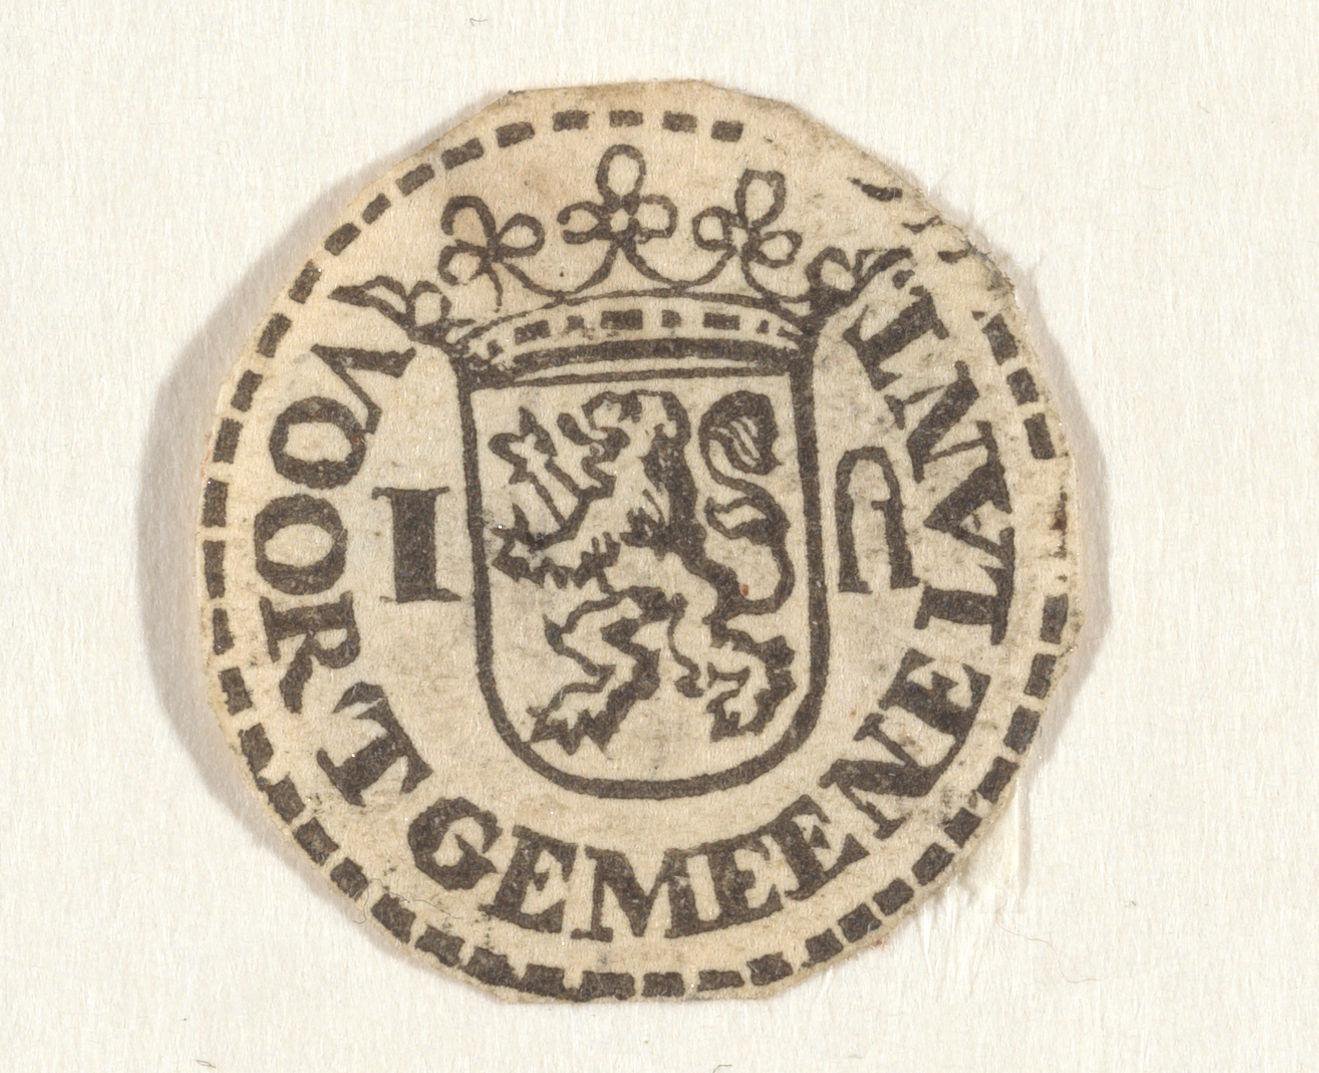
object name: print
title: Penning met een wapen met daarop een leeuw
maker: Anonymous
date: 1600-1699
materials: paper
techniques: woodcut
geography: netherlands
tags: coat of arms (as symbol of the state, etc.), coin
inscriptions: collector's mark: Lugt 240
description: Een wapen met daarop een leeuw met een kroon in een cirkel met randschrift.